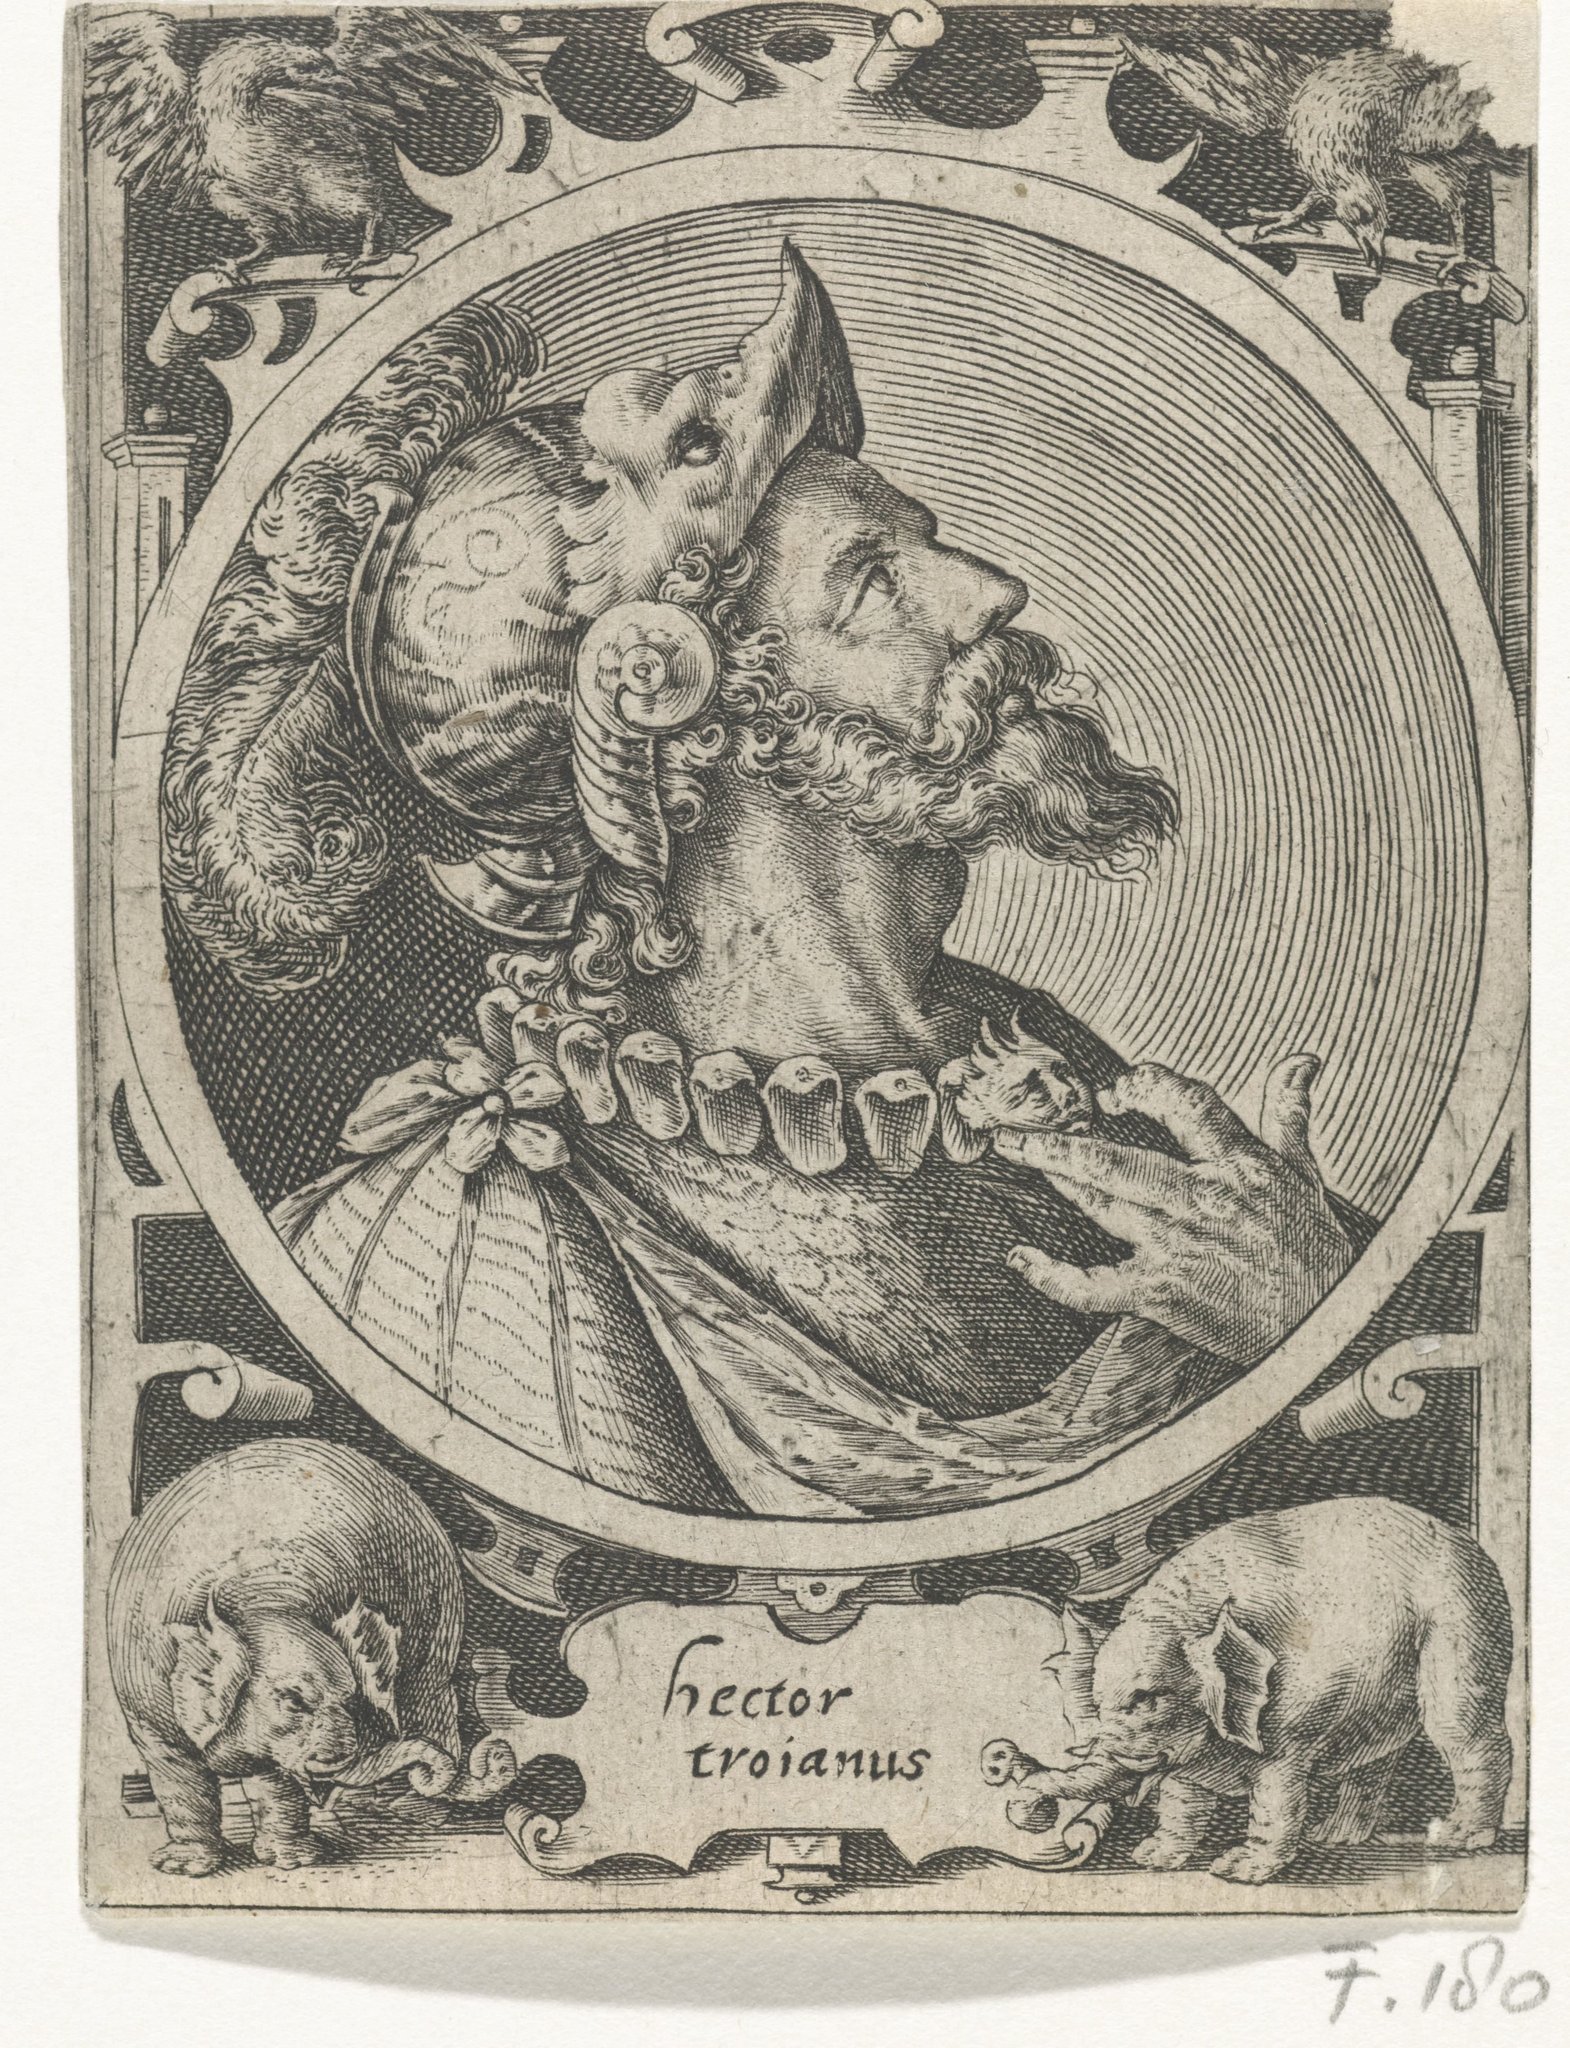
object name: print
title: De negen helden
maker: crispijn van de passe (i)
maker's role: draughtsman, print maker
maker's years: 1564-1637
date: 1574-1637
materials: paper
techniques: engraving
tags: hector (one of the nine worthies)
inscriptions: collector's mark: Lugt 2228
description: De held uit de klassieke oudheid Hector van Troje. Buste gevat in een medaillon met daaronder een cartouche met zijn naam. In de onderhoeken twee olifanten en in de bovenhoeken twee adelaars. Prent uit een serie van negen met helden.